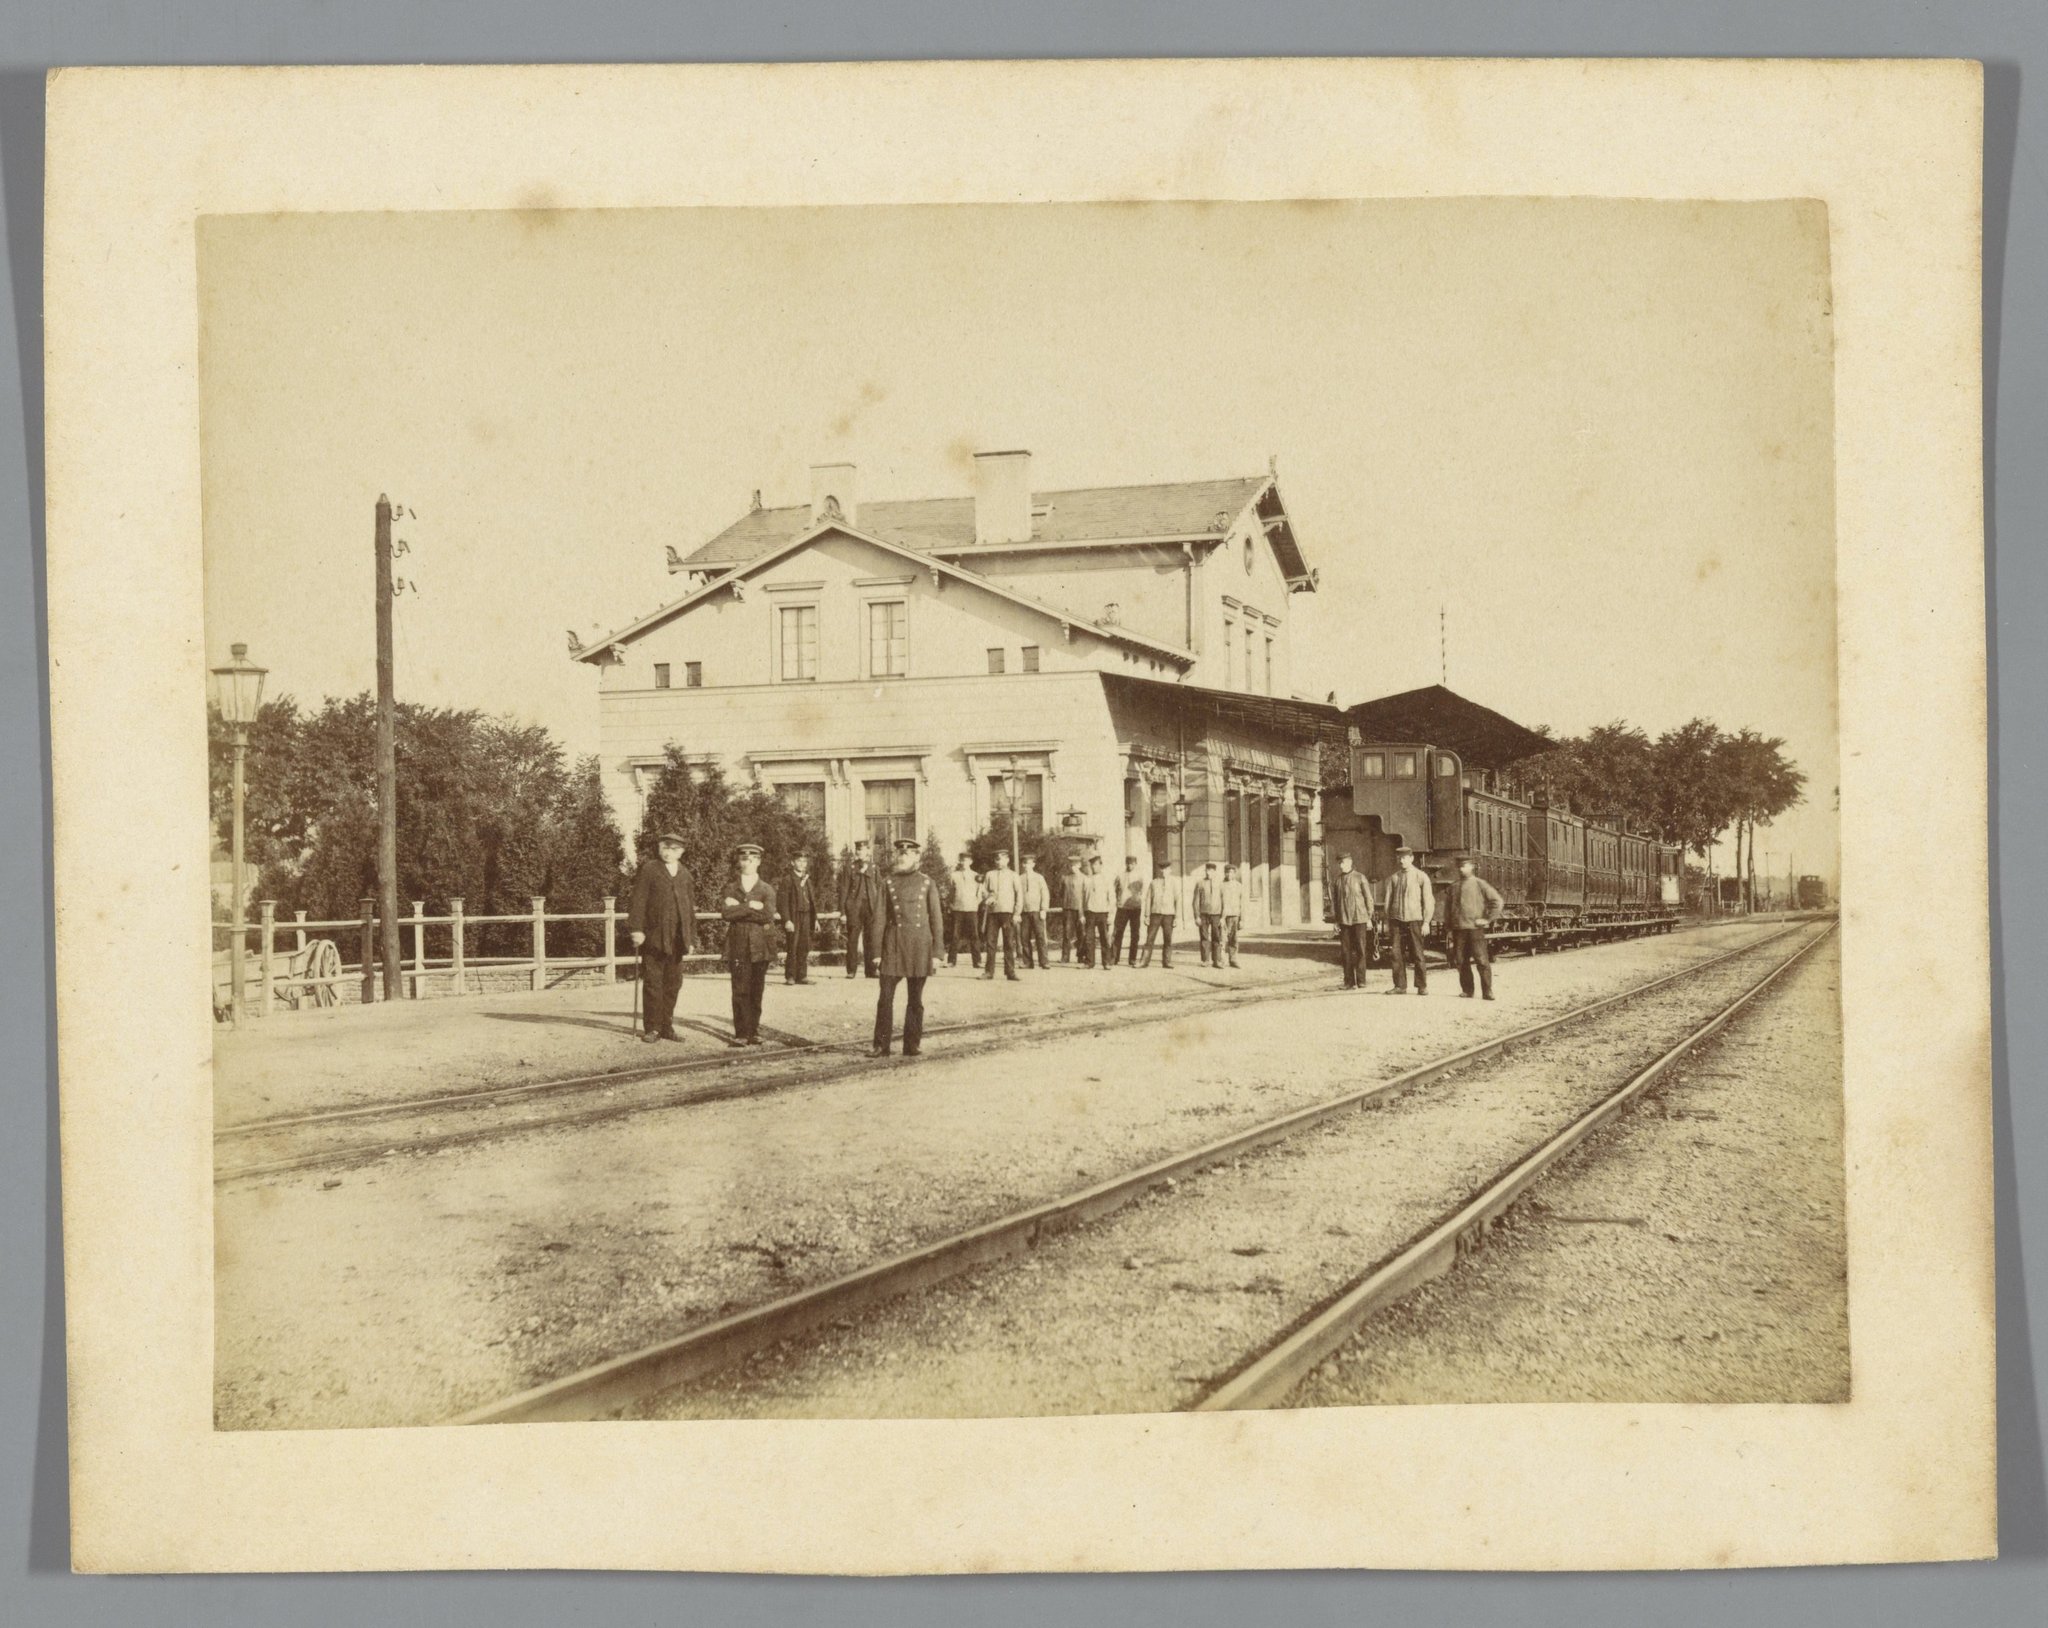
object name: photograph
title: Spoorwegstation nabij Kleef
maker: Anonymous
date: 1880-1900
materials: cardboard, paper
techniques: albumen print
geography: cleves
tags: station; shelter (railway, tramway), cleves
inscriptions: collector's mark: ‘Vosmaer’